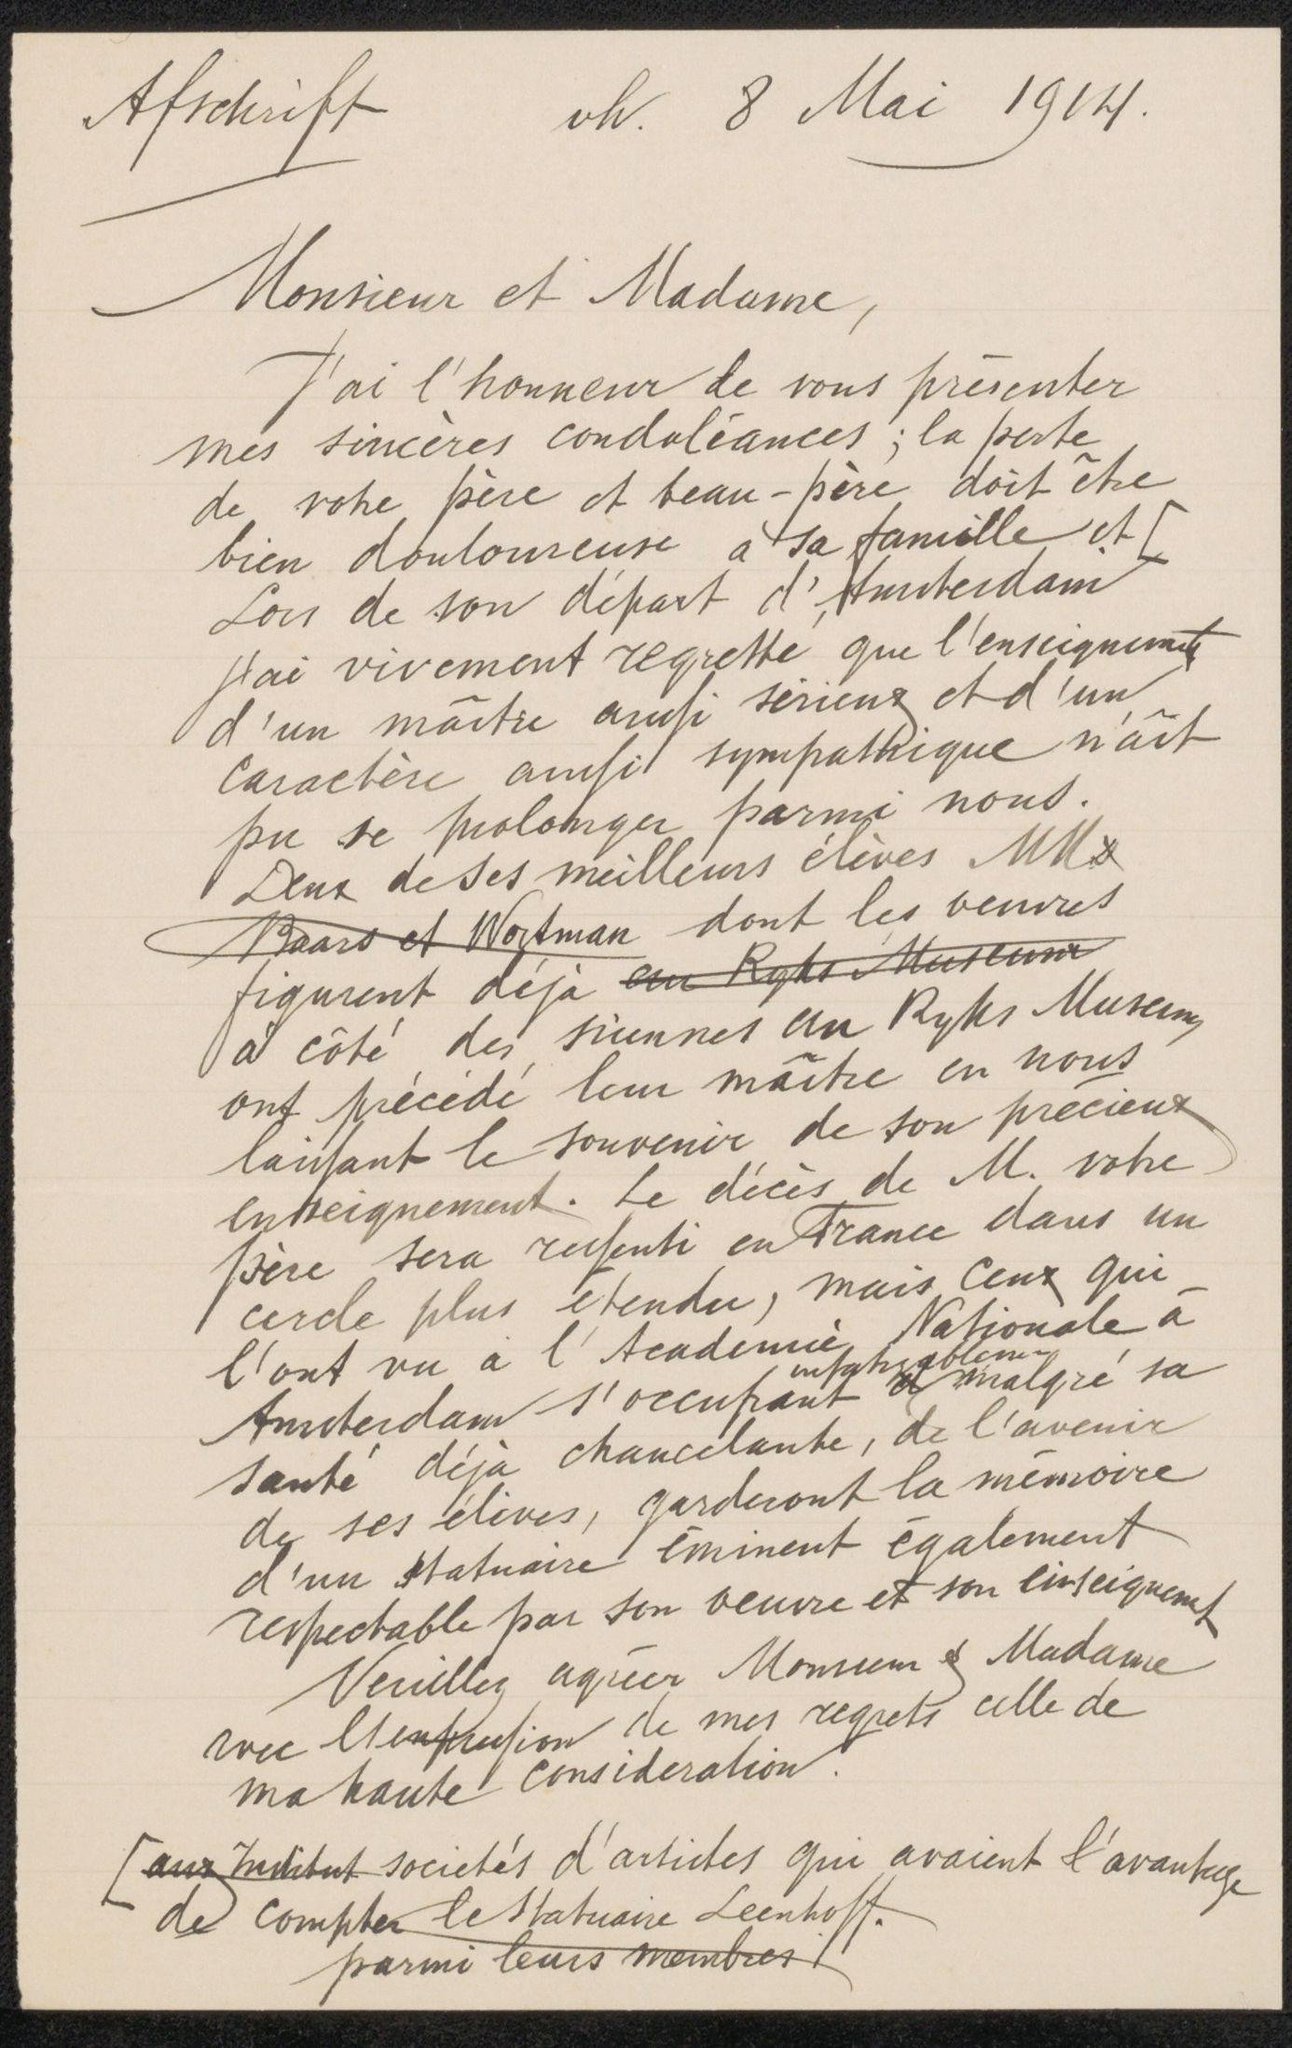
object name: letter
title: Brief aan onbekend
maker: august allebé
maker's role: draughtsman, print maker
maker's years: 1838-1927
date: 1914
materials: ink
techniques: pen, writing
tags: ferdinand leenhoff, johannes hendrik philip wortman, sculptor, johan hendrik baars, family life, education, tuition of the artist (in general), amsterdam